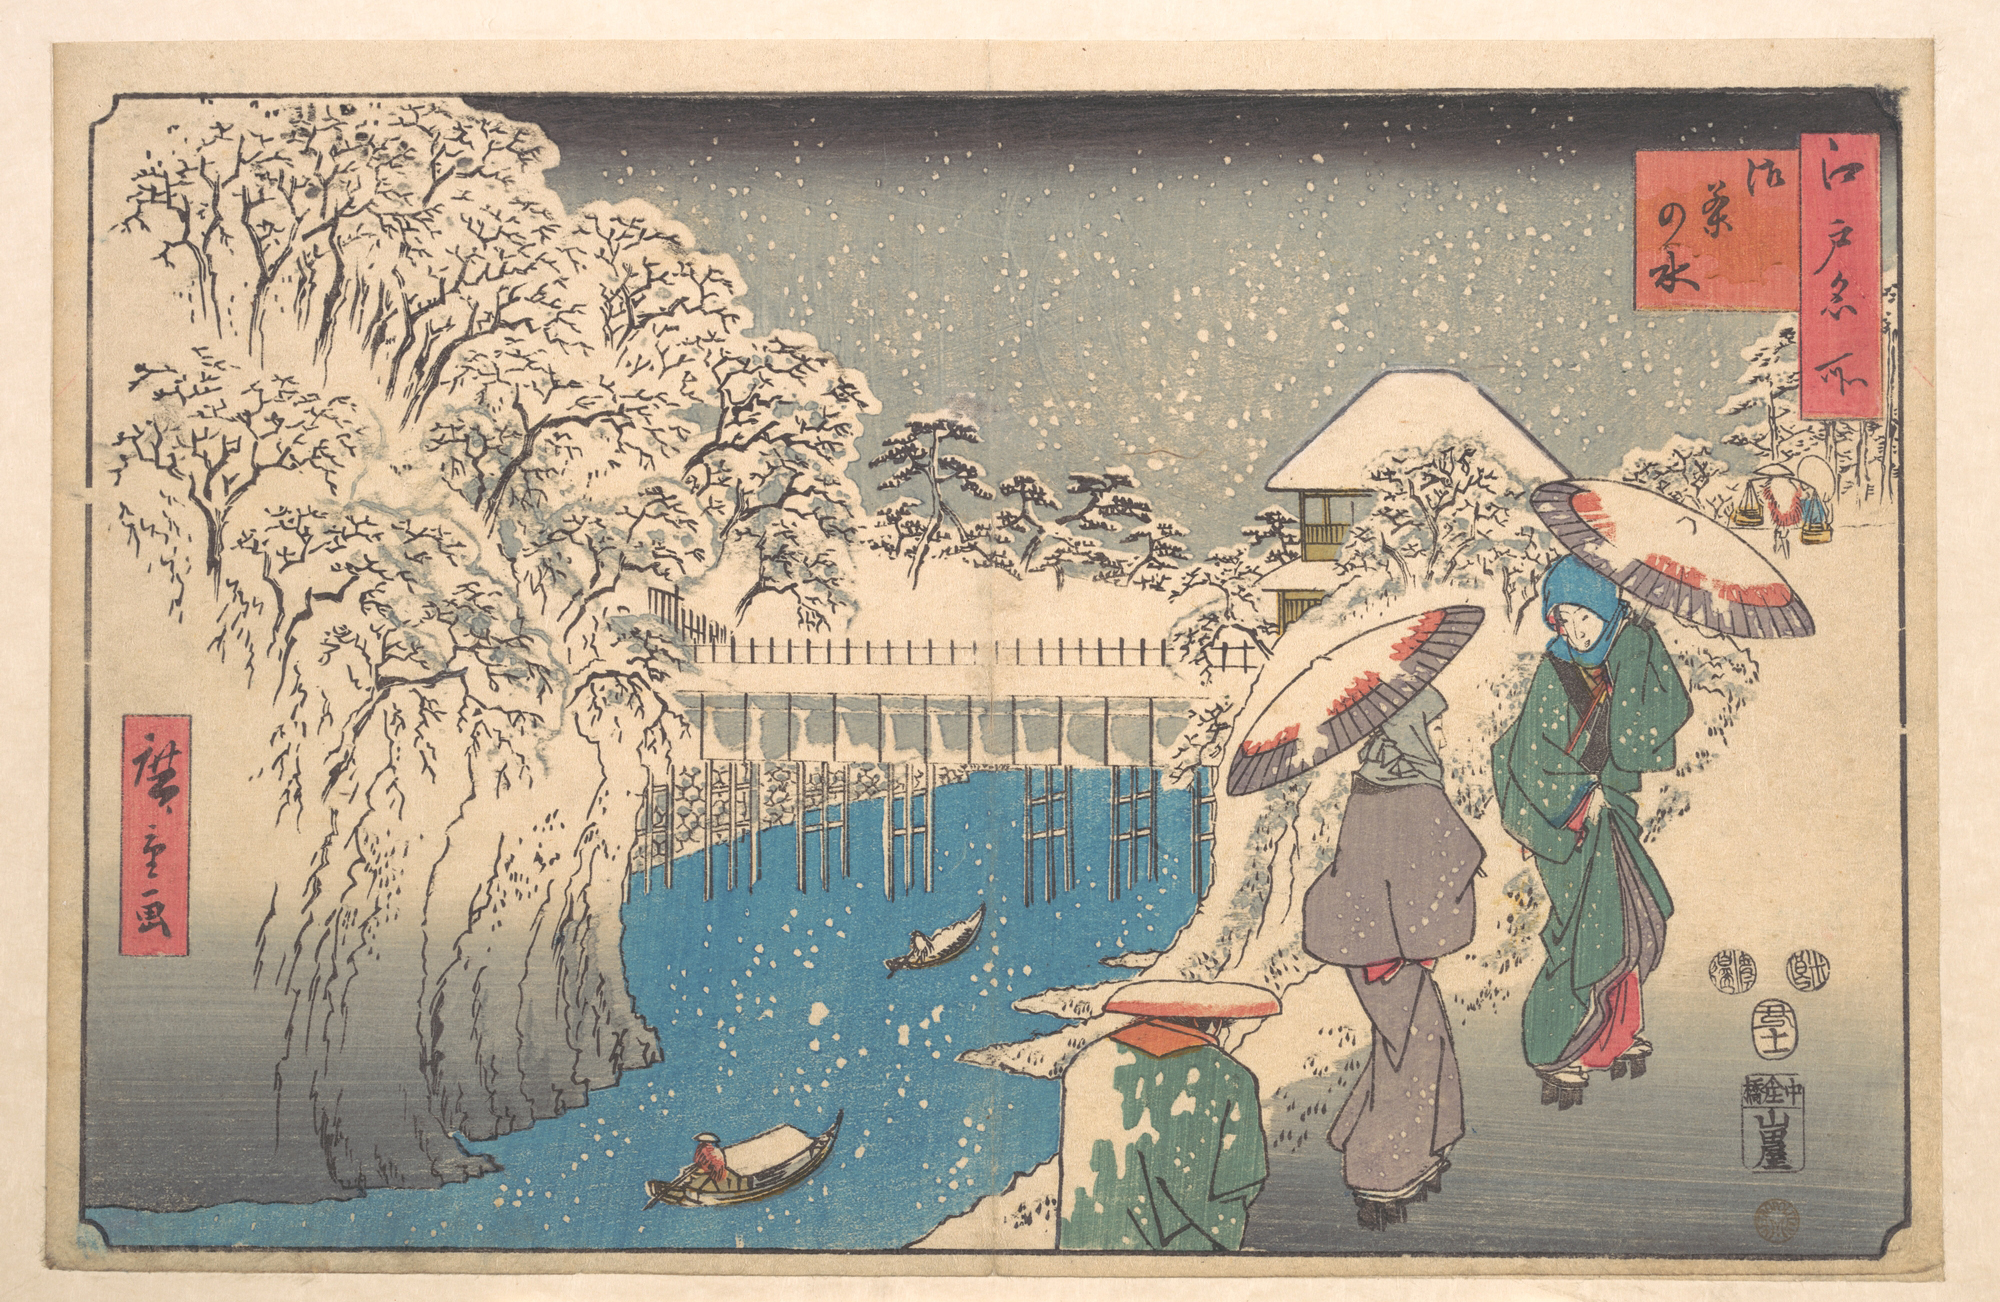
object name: print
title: Ochanomizu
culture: japanese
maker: utagawa hiroshige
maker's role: artist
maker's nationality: japanese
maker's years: 1797-1858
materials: ink, paper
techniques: woodblock print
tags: bridges,trees,snow,boats